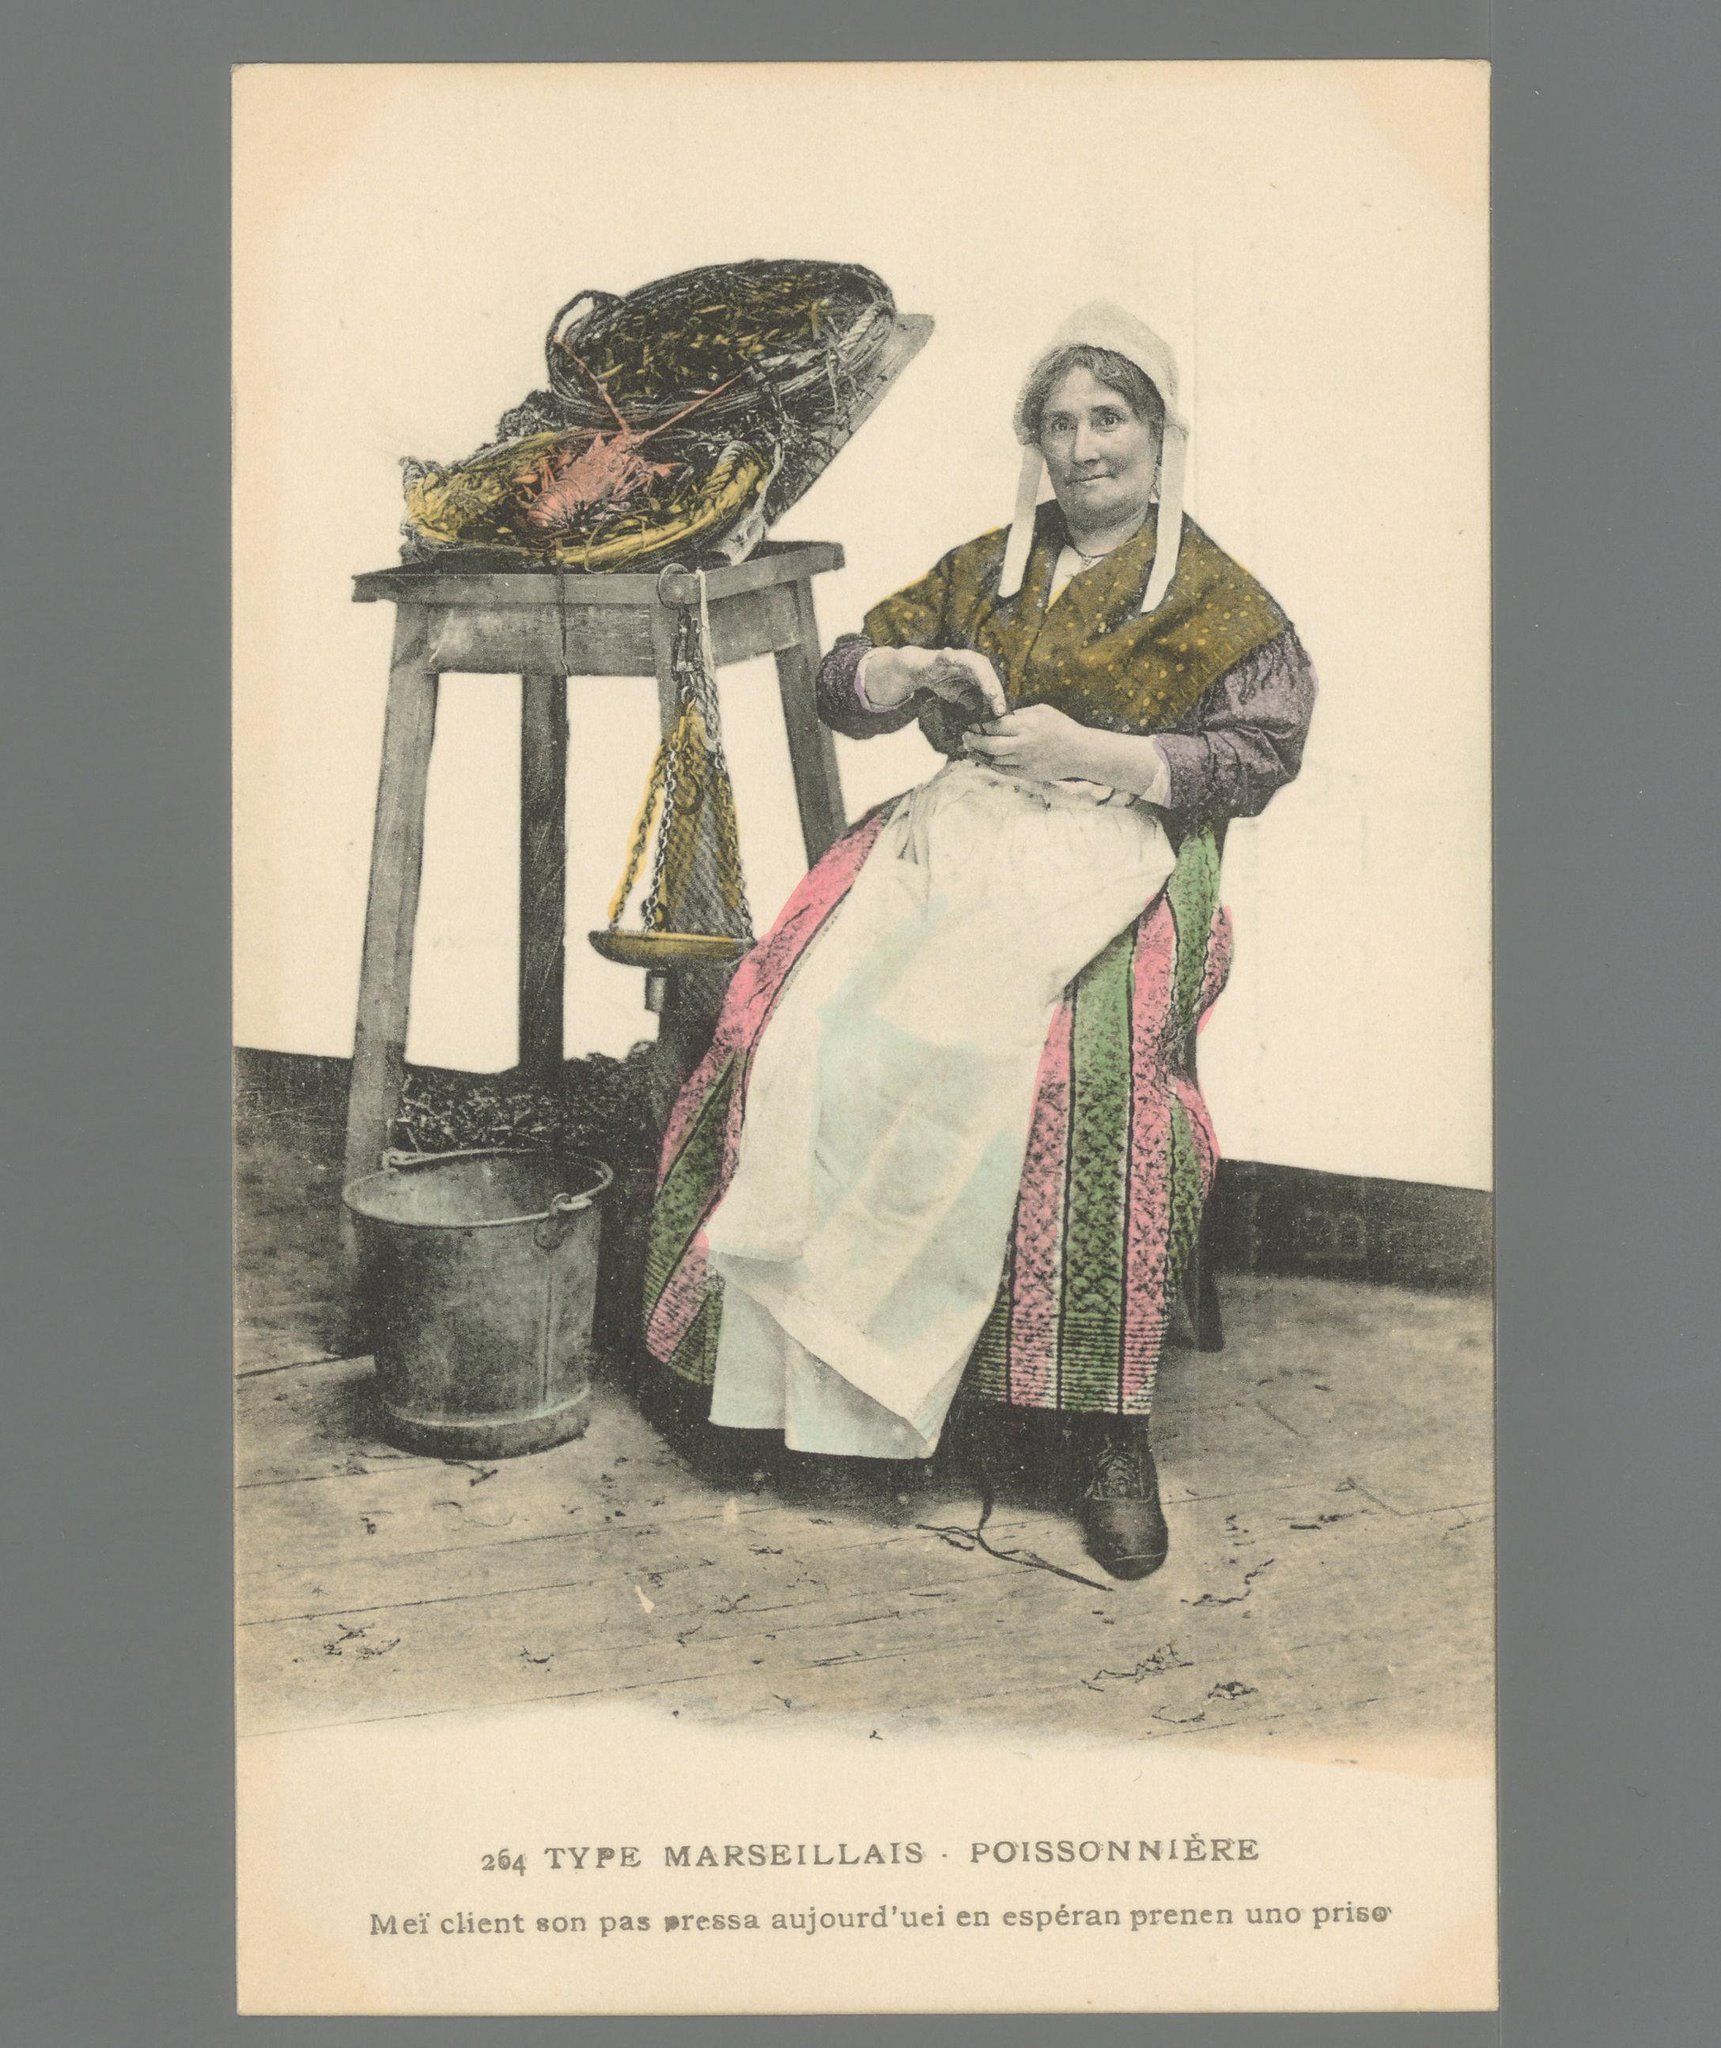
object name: ansichtkaart, prentbriefkaart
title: Type Marseillais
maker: Anonymous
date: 1904-1906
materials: cardboard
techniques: photograph, hand coloring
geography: marseille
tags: adult woman, persons engaged in trade and commerce, sea and coastal fishery, marseille